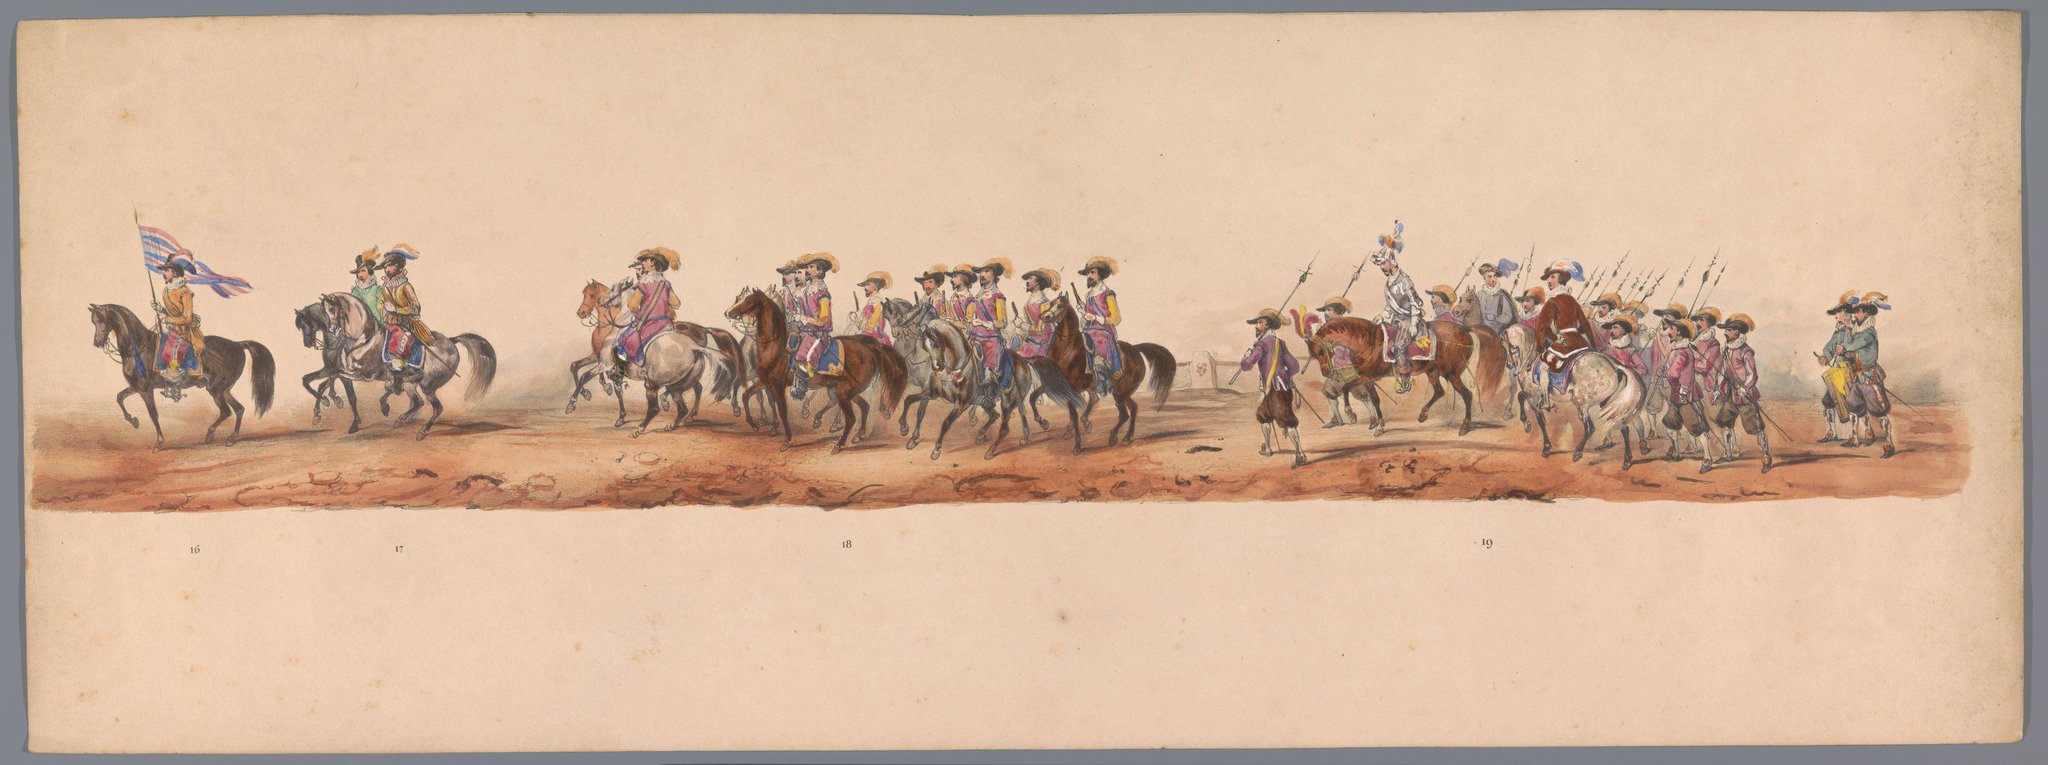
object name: print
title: Optogt des Nederlandschen Legers naar Ostende, den 3 July 1600, daags na de overwinning by Nieuwpoort; volgens de gecostumeerde voorstelling, gegeven door H H Studenten, by gelegenheid van het Tweede Eeuwfeest der Utrechtsche Hoogeschool. den 16 Juny 1836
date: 1837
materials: paper, watercolor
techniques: hand coloring, lithograph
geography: utrecht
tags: students' pageant, costumes used in pageants, battle of nieuwpoort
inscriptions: date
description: Historische gekostumeerde optocht van de studenten van de Hogeschool van Utrecht op 16 juni 1836, bij de viering van het tweede eeuwfeest van de Utrechtse Hogeschool. De optocht verbeeldt de intocht van het Staatse leger in Oostende op 3 juli 1600, daags na de overwinning in de Slag bij Nieuwpoort. Vijfde plaat in een serie van tien ongenummerde platen, met de groepen genummerd 16-19.